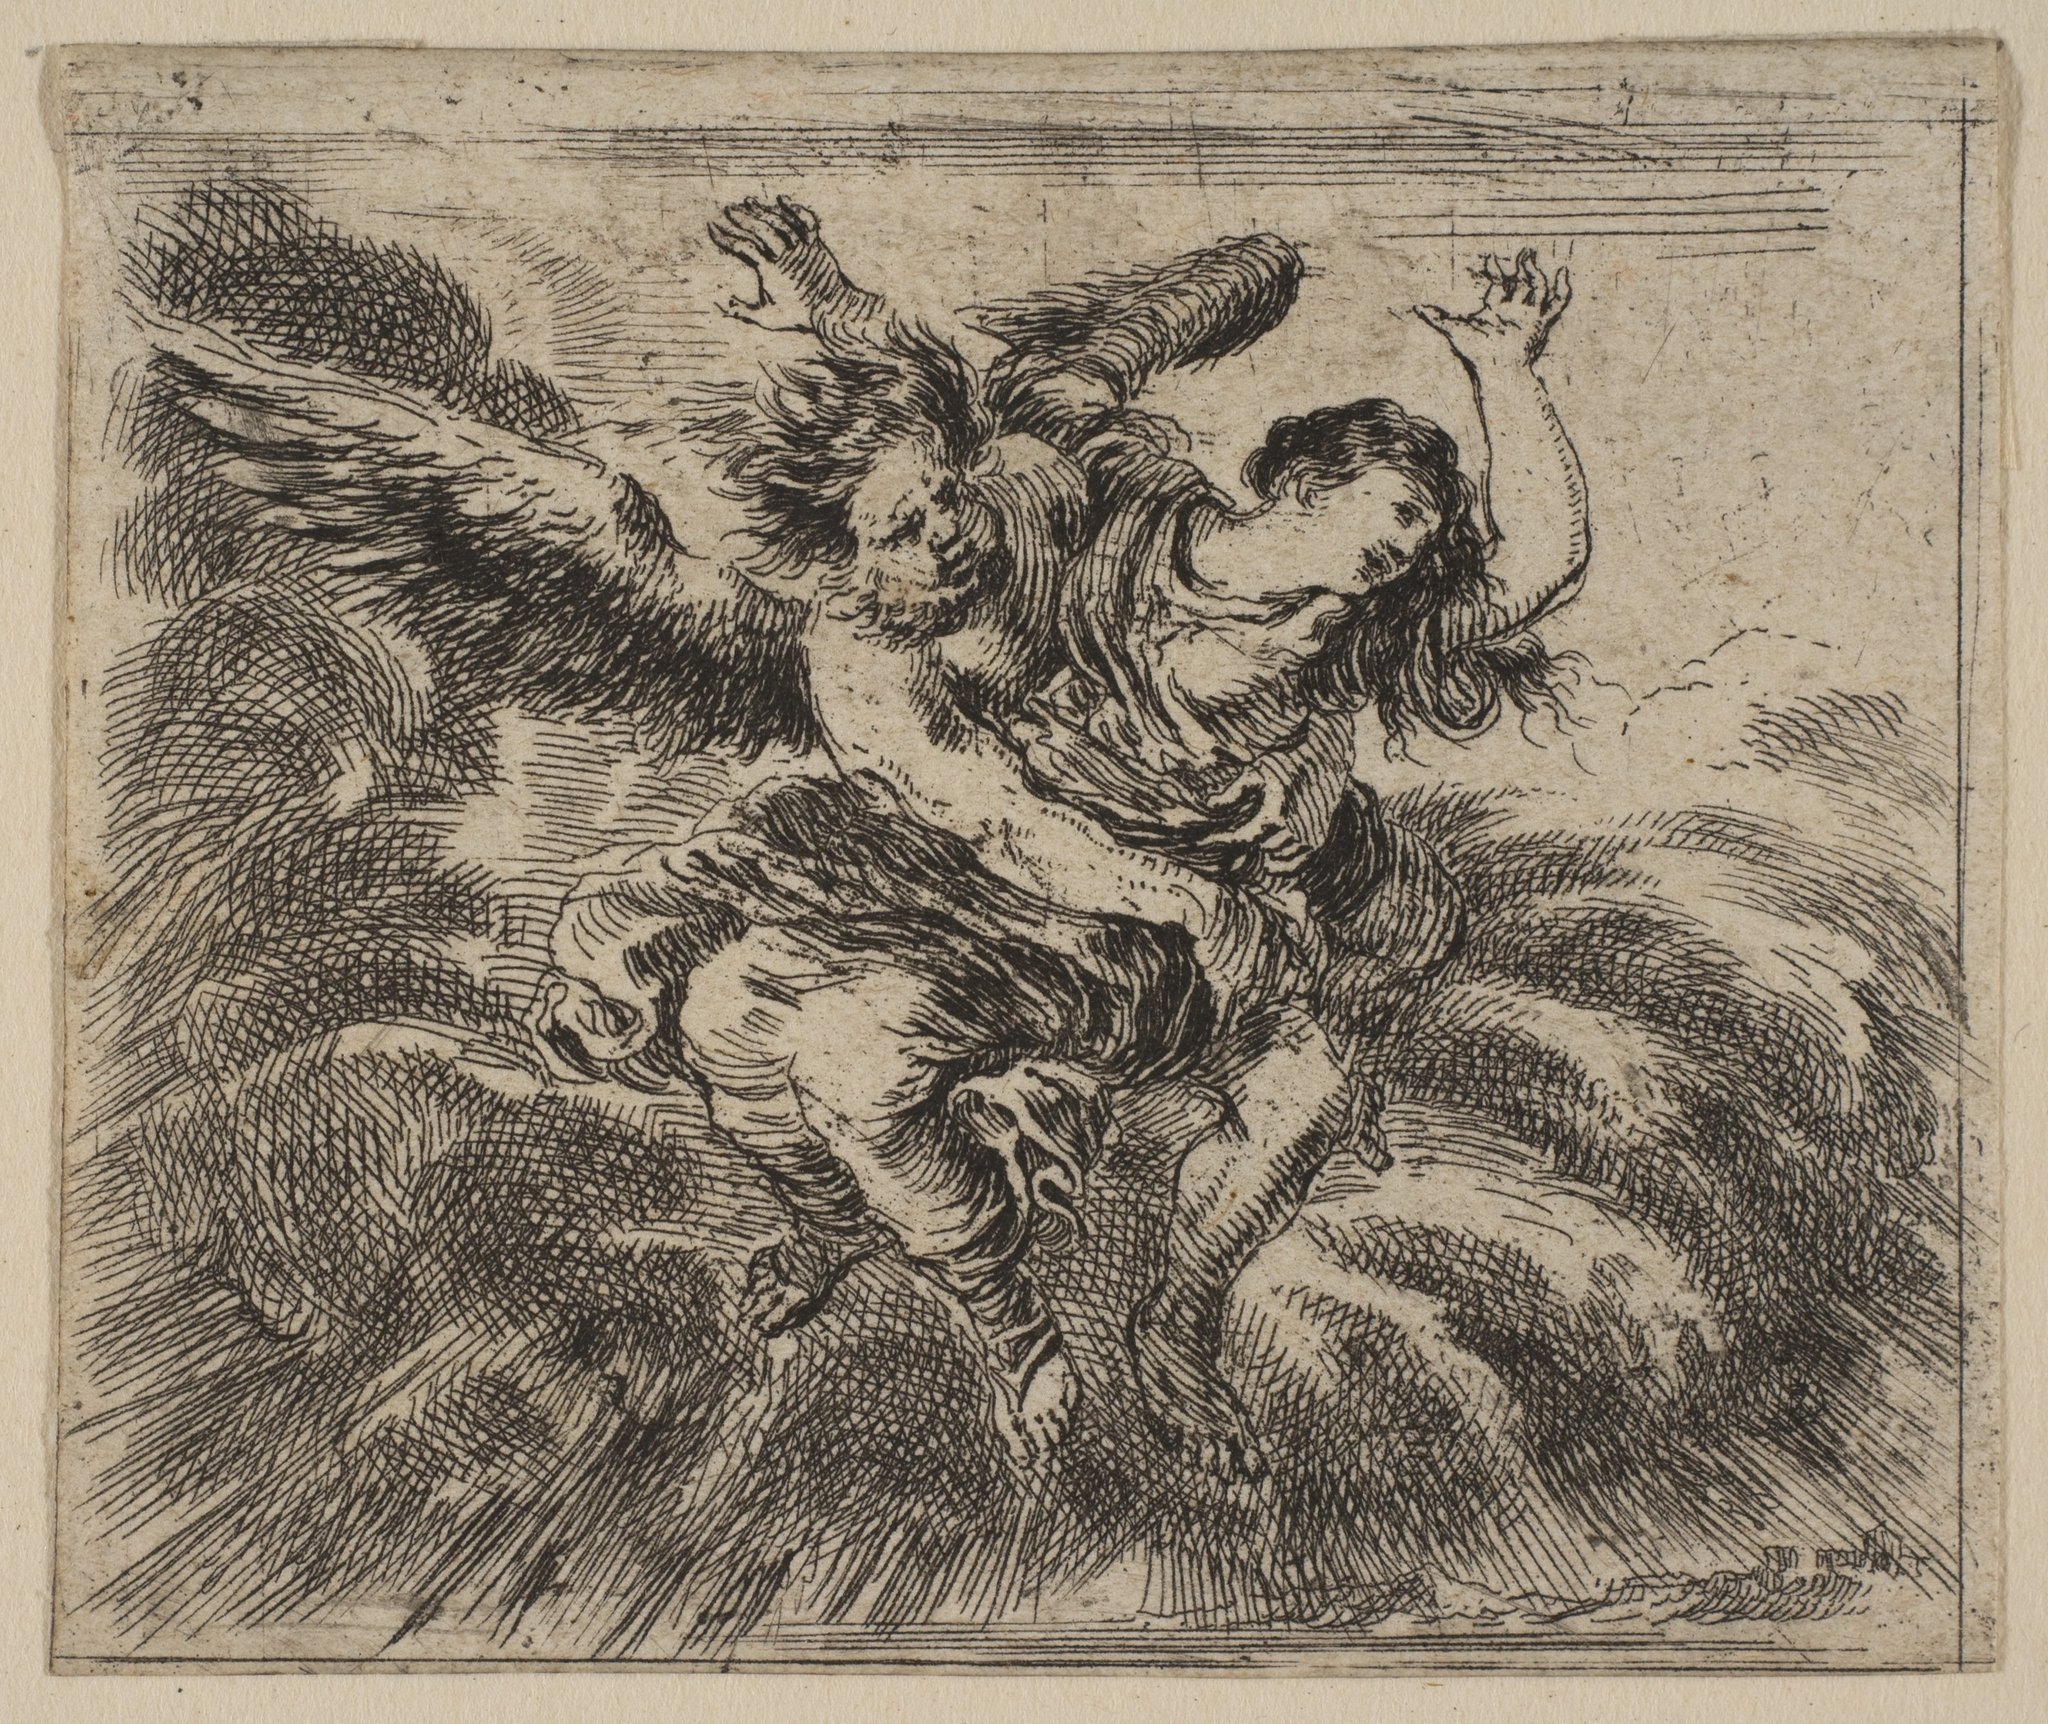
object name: print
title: Boreas and Oreithyia, from 'Game of Mythology' (Jeu de la Mythologie)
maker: stefano della bella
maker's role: artist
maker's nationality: italian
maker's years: 1610-1664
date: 1644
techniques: etching